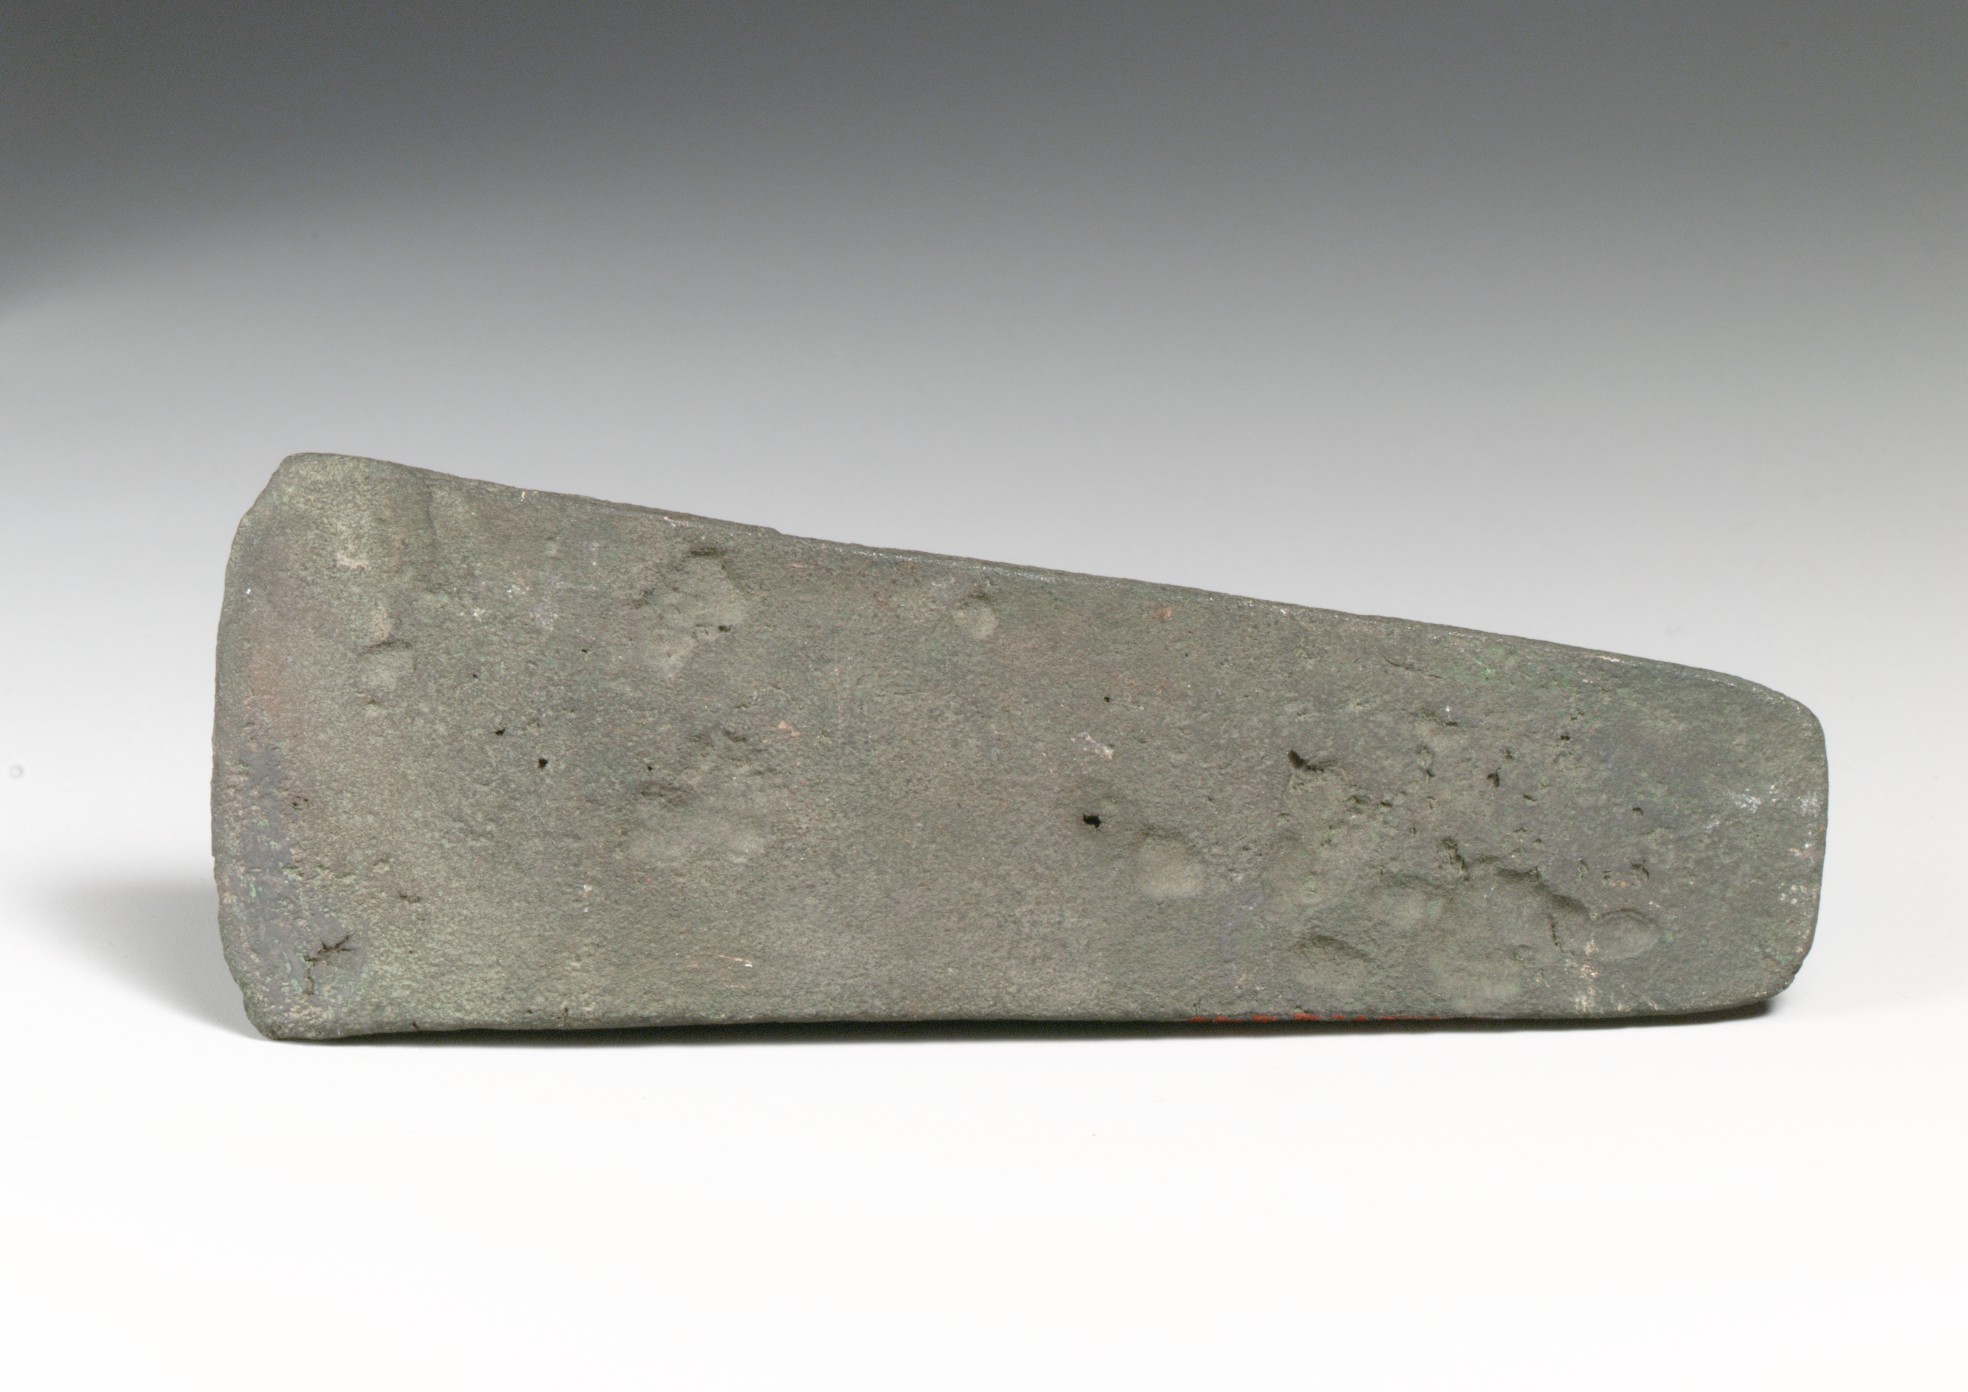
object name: axehead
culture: cypriot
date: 3200-2000 BCE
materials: bronze